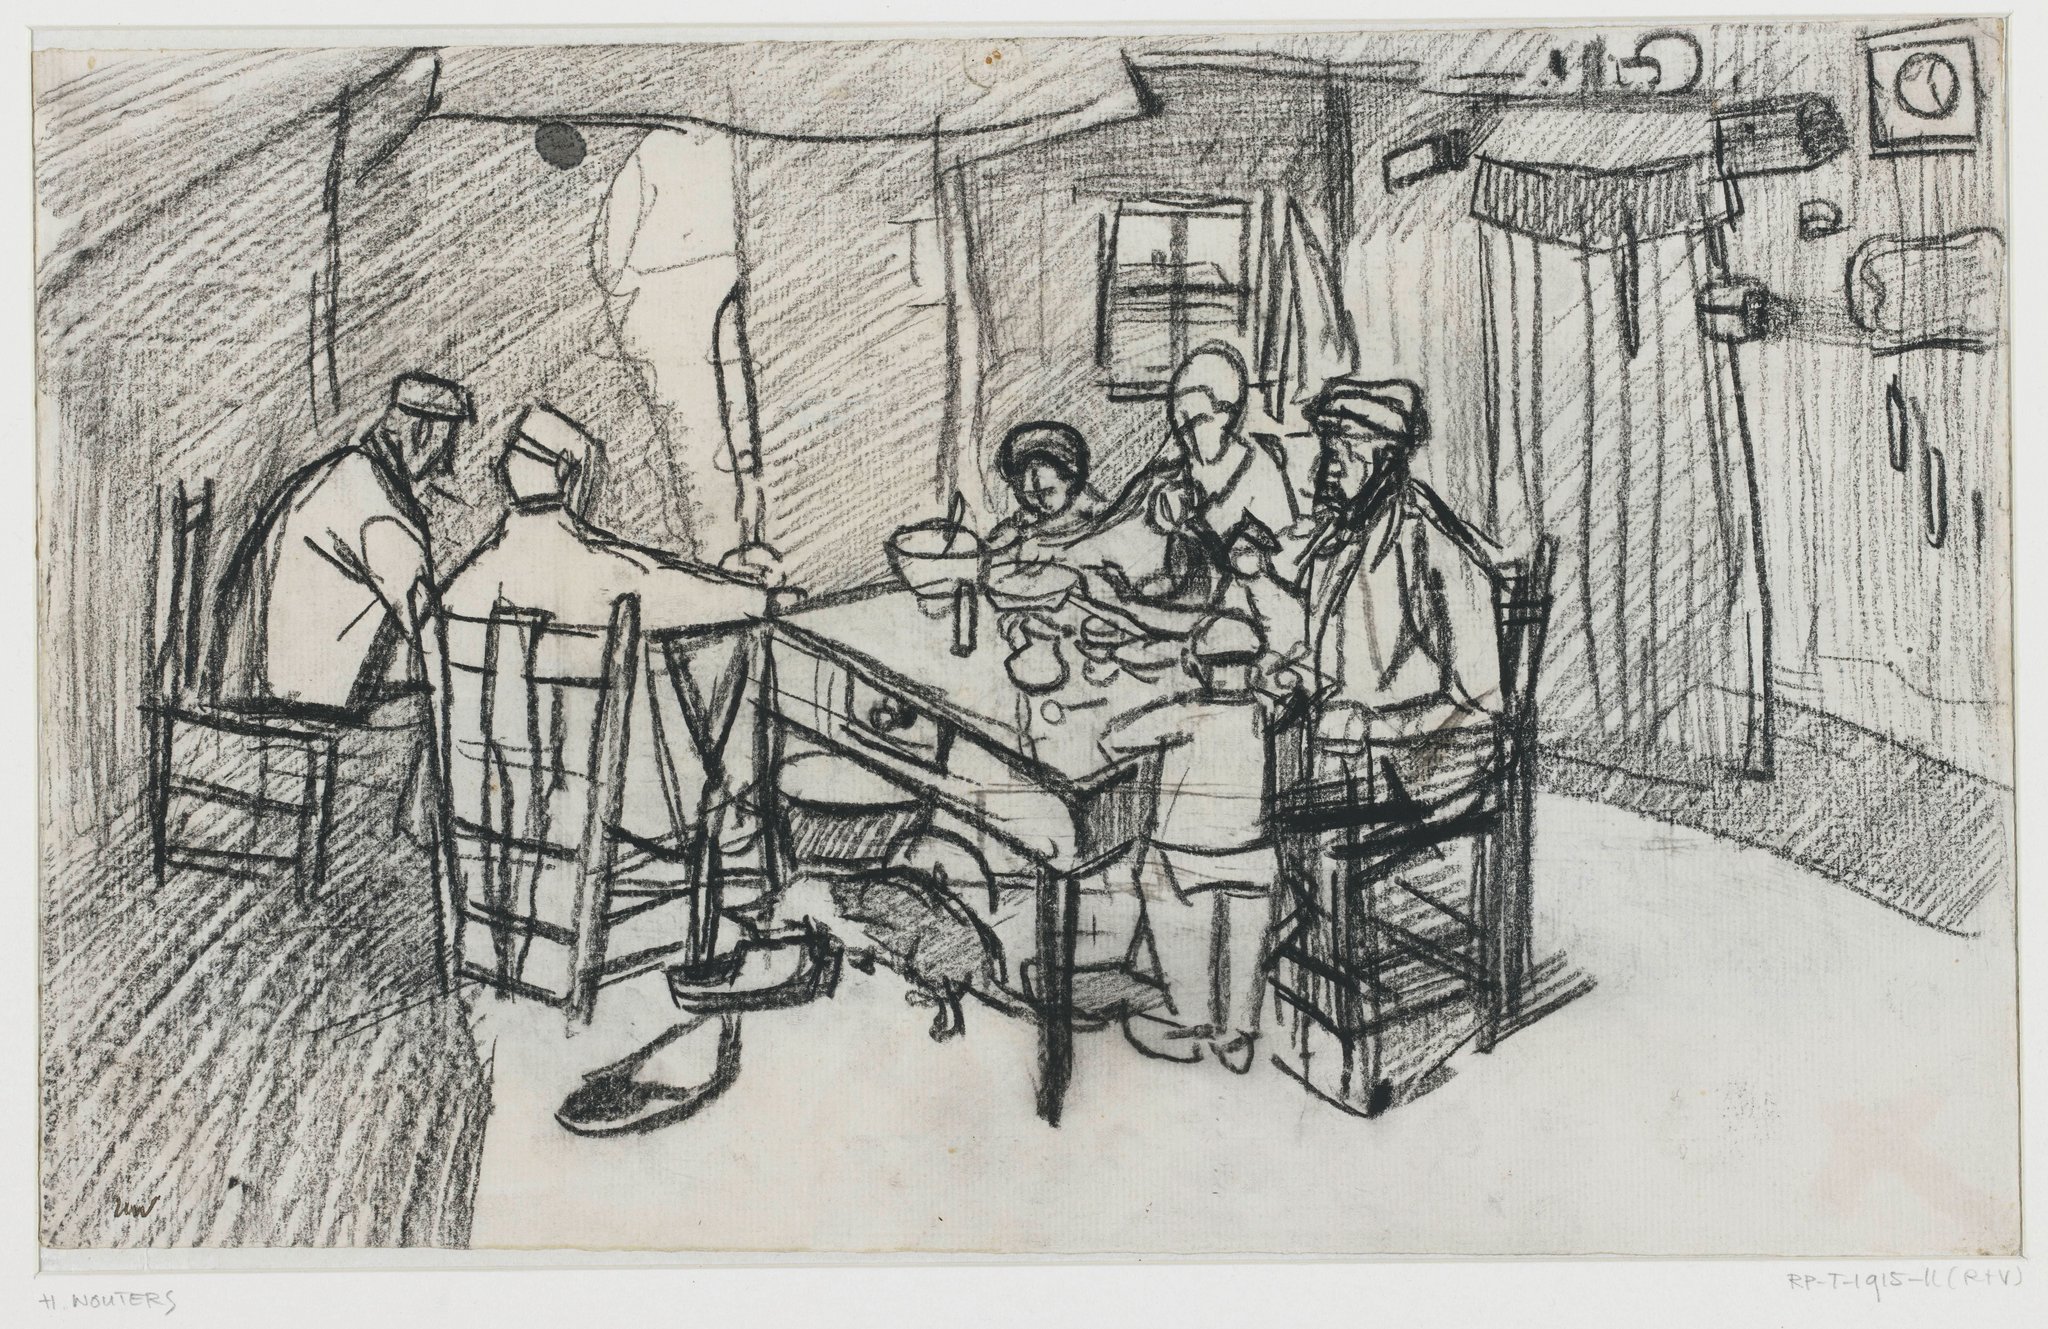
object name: drawing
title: Boereninterieur met familie aan tafel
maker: henri wouters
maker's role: draughtsman, print maker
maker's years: 1866-1935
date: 1876-1915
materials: chalk, paper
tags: interior of the house, farm (building), eating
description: Boereninterieur met familie aan tafel; met een jongetje dat aan tafel staat.